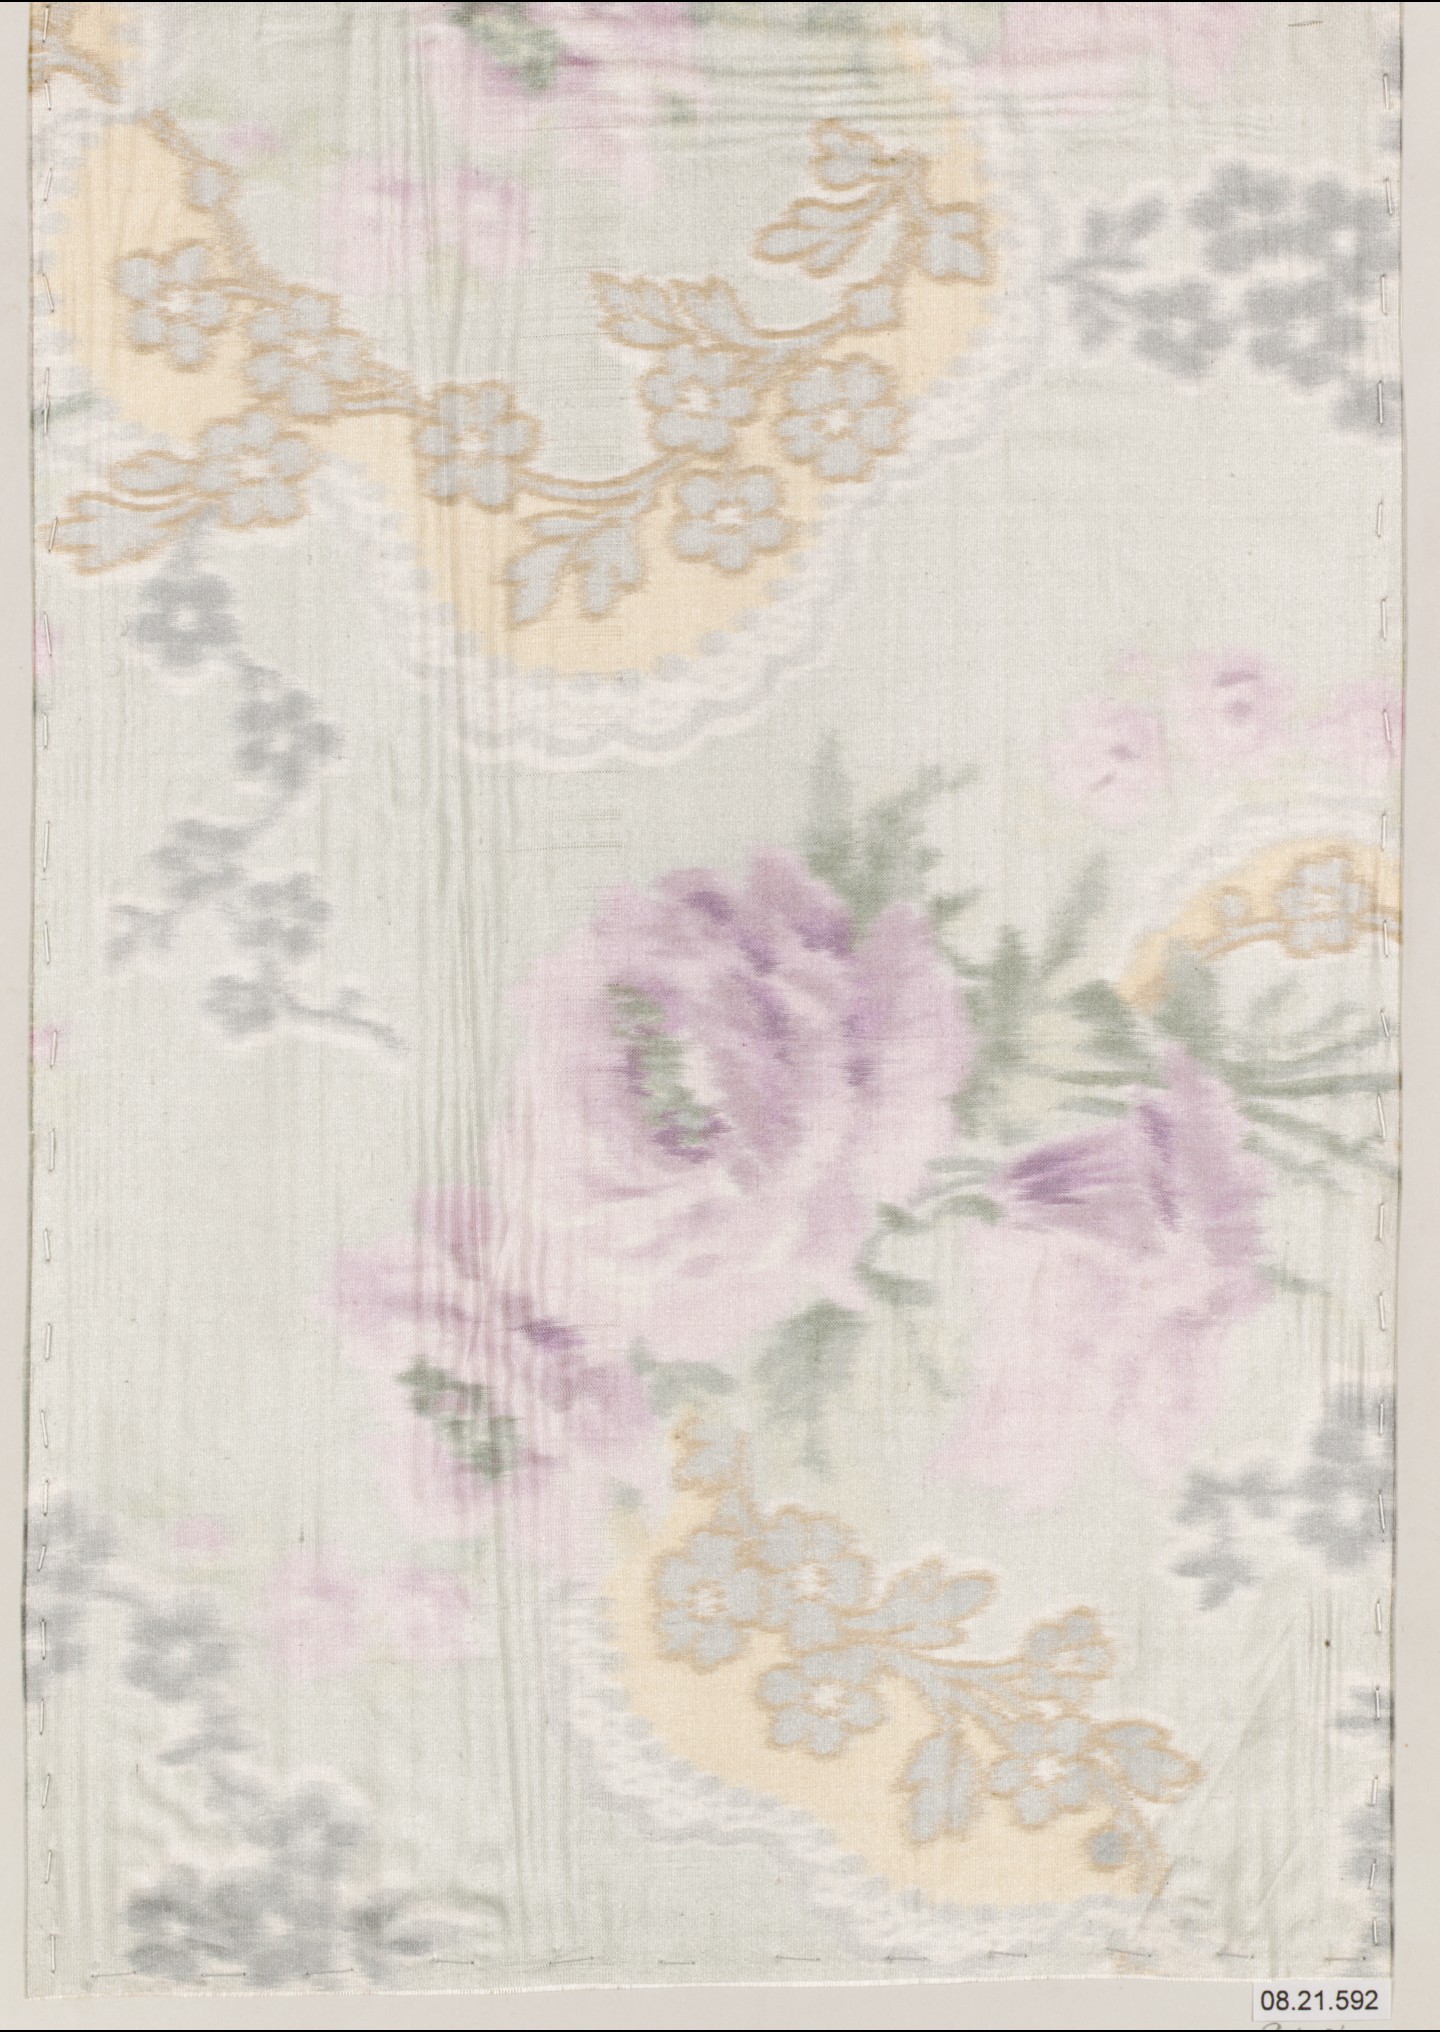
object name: textile sample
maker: Anonymous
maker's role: designer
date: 1900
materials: silk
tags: flowers